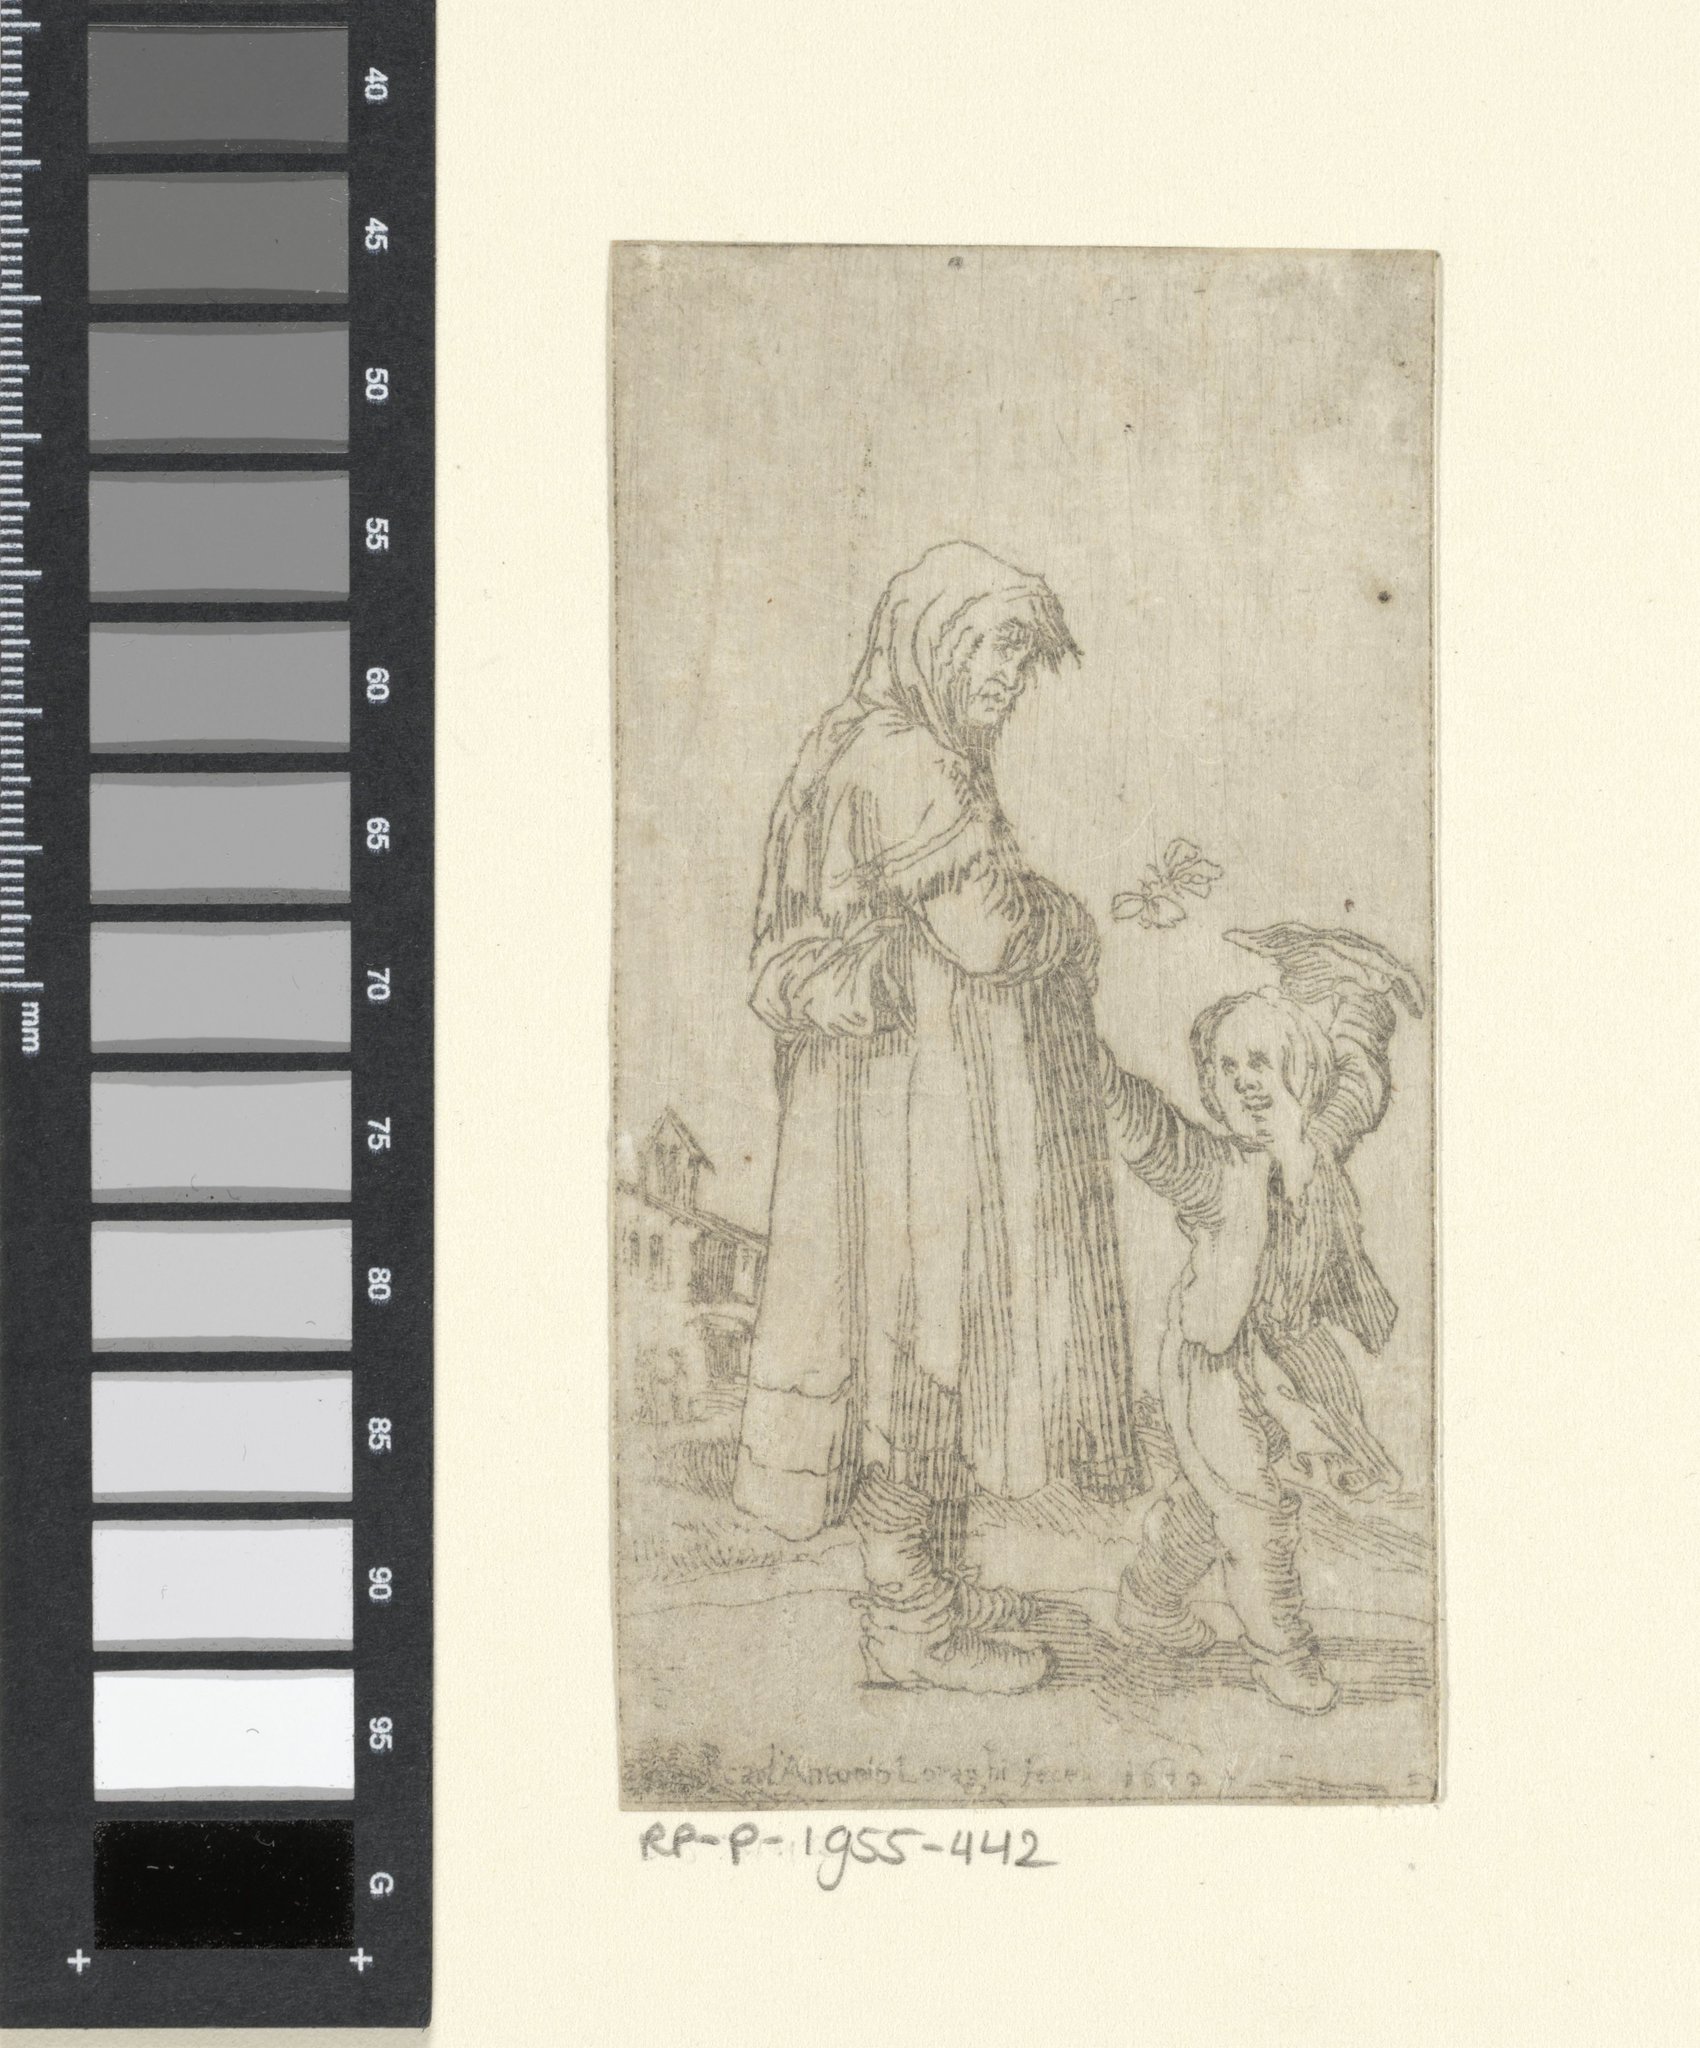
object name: print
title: Boerin met jongen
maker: antonio loraghi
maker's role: print maker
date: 1672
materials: paper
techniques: etching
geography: italy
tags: mother and son(s) (family group), farmers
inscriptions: collector's mark: Lugt 2228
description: Een boerin met haar zoon. De jongen houdt zijn hoed in zijn hand. In de lucht vliegen twee vlinders.